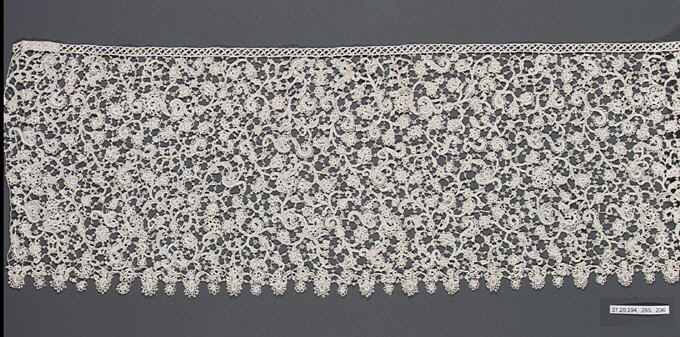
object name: border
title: Border (one of three joined)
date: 1701-1733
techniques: lace